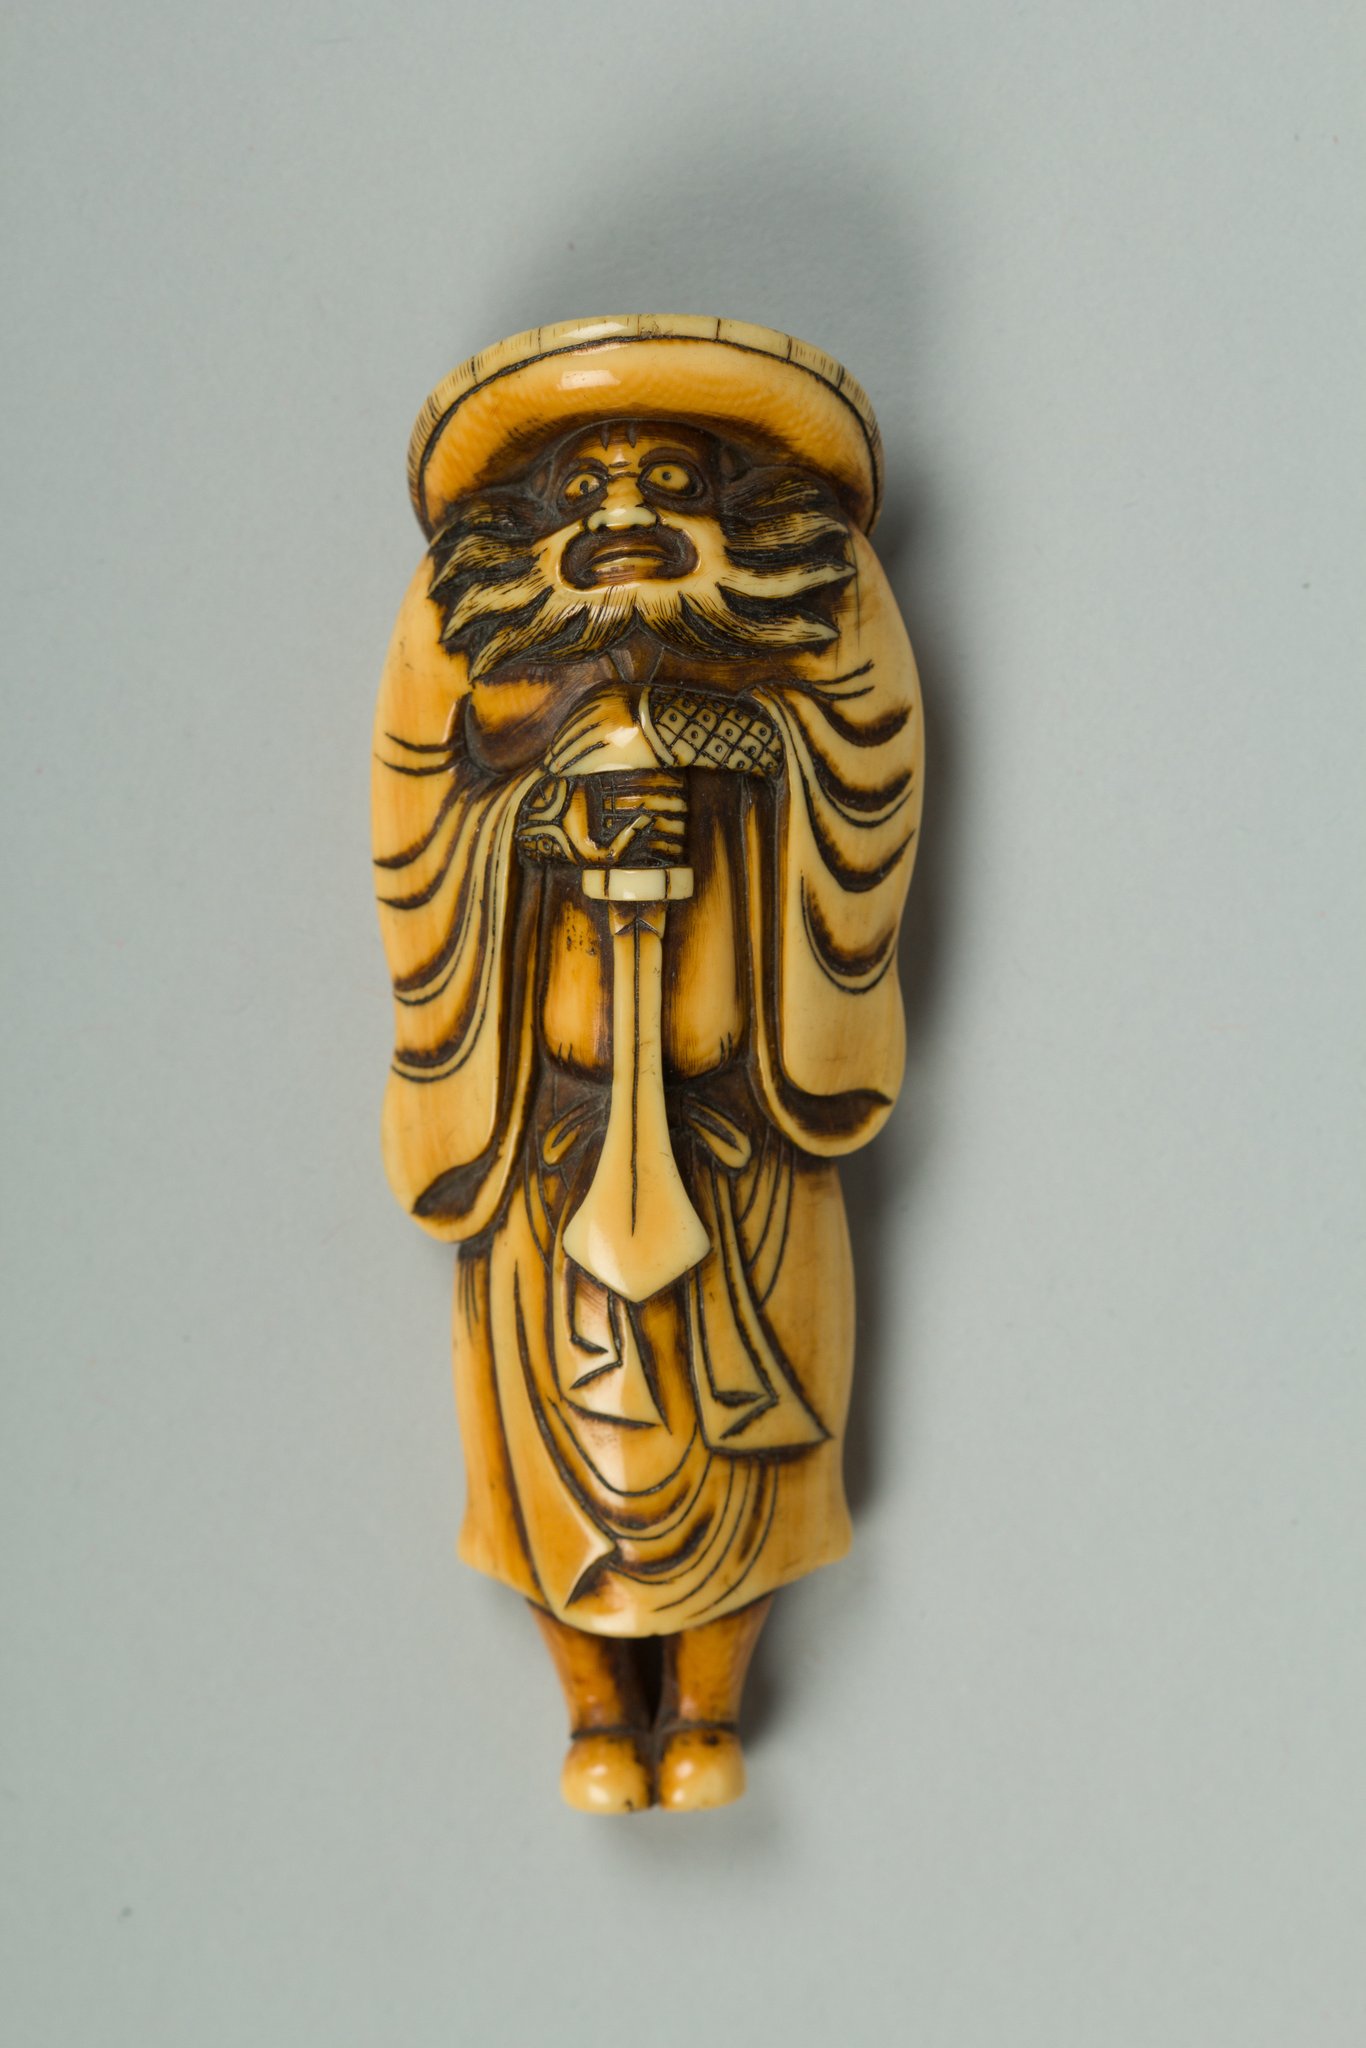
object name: netsuke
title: Netsuke of a Man Carrying a Sword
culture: japanese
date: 1801-1900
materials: ivory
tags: men